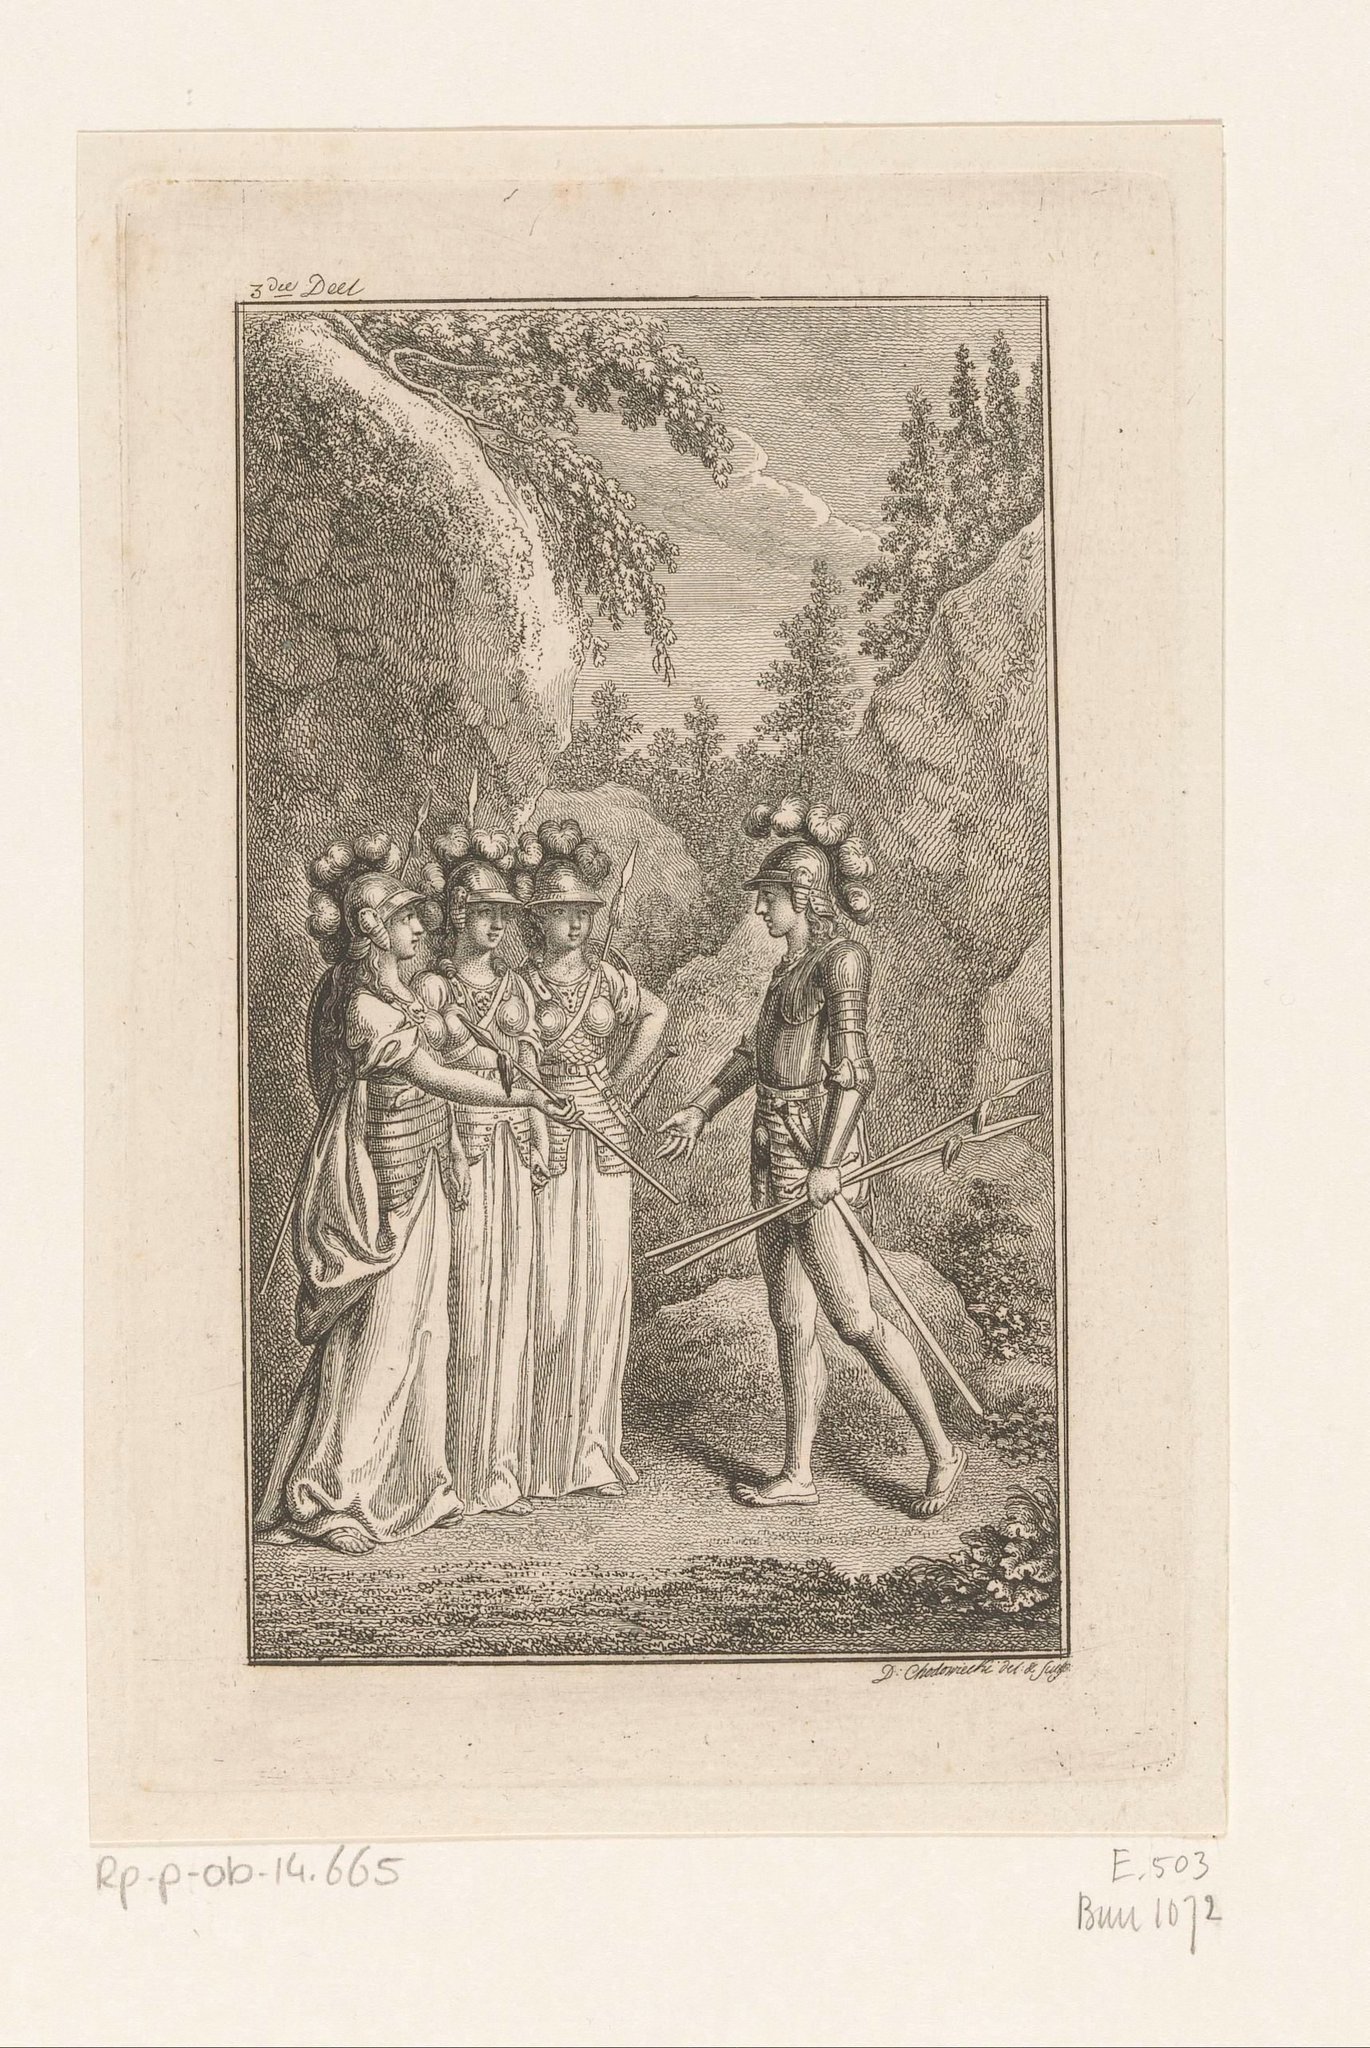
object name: print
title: Hoder krijgt een speer van de Walkuren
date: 1784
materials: paper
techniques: etching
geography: berlin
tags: germanic and scandinavian religions, representations ~ gods, demi-gods, heroes etc. (germanic and scandinavian religions), casting weapons: spear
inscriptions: collector's mark: Lugt 2228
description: Prent uit: Ewald, Johannes. Balder's Tod. Ein traurspiel mit Gesang (...). 2de druk. Kopenhagen: Christ. Gottlob Proft, 1785.